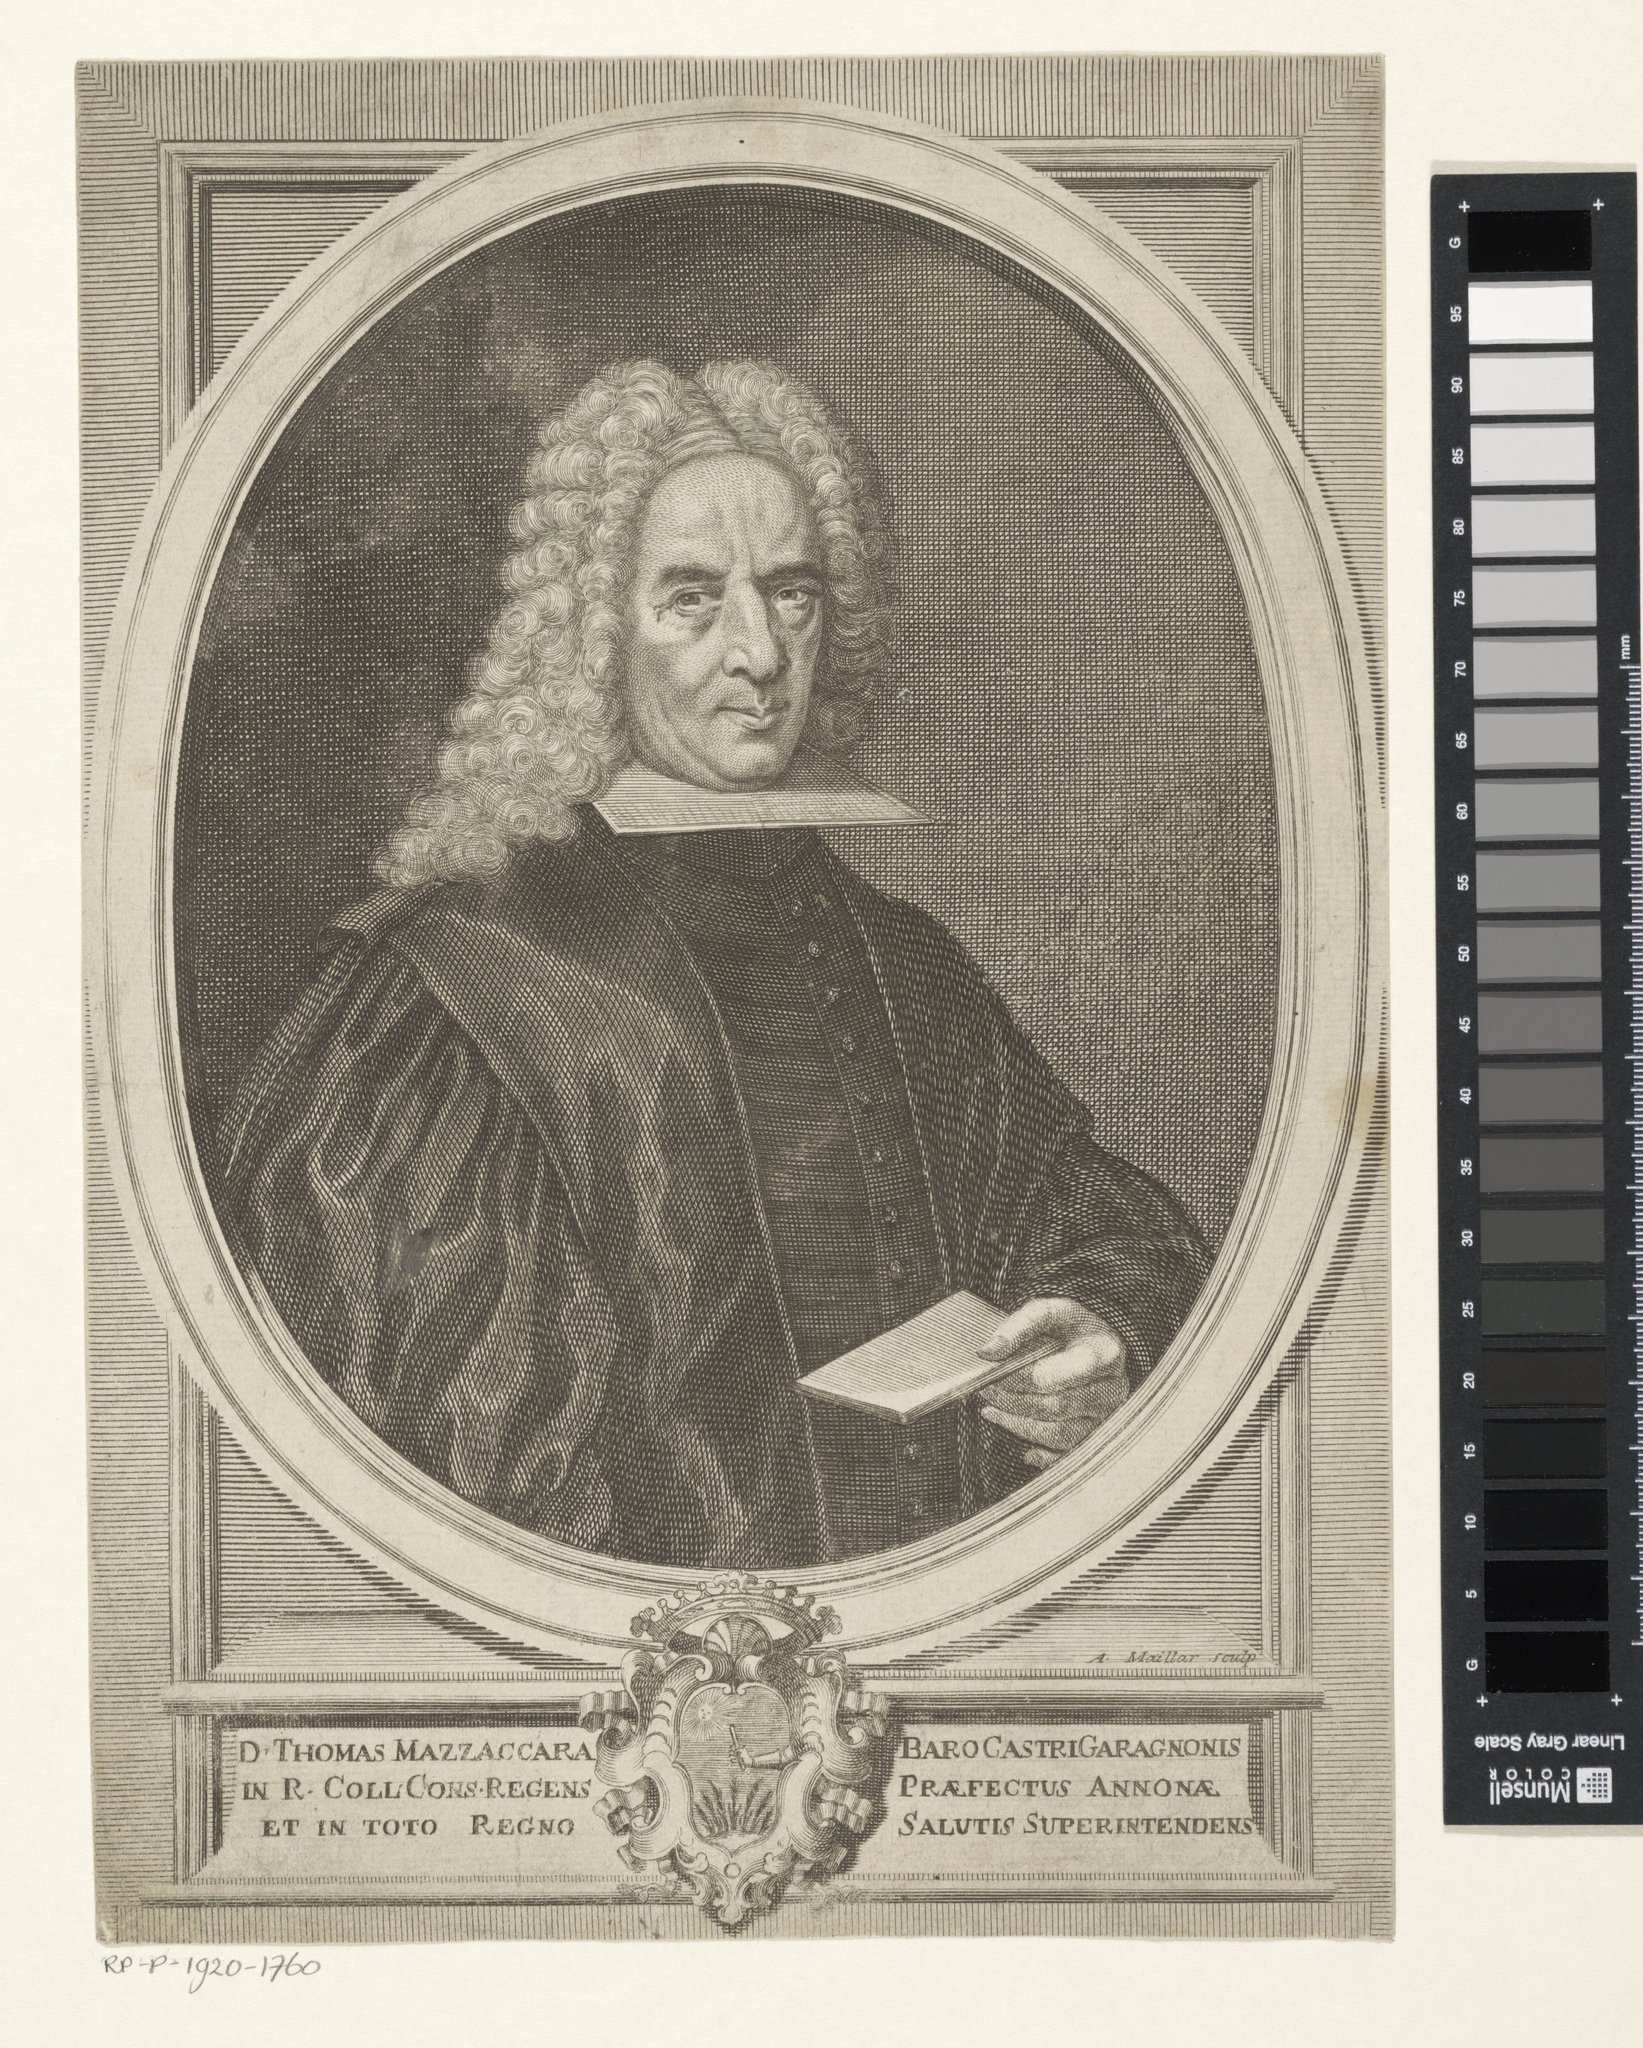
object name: print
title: Portret van Thomas Mazzaccara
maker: andrea magliar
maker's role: draughtsman, print maker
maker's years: 1690-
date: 1700-1799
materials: paper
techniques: engraving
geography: italy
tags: historical persons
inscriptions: collector's mark: Lugt 2228